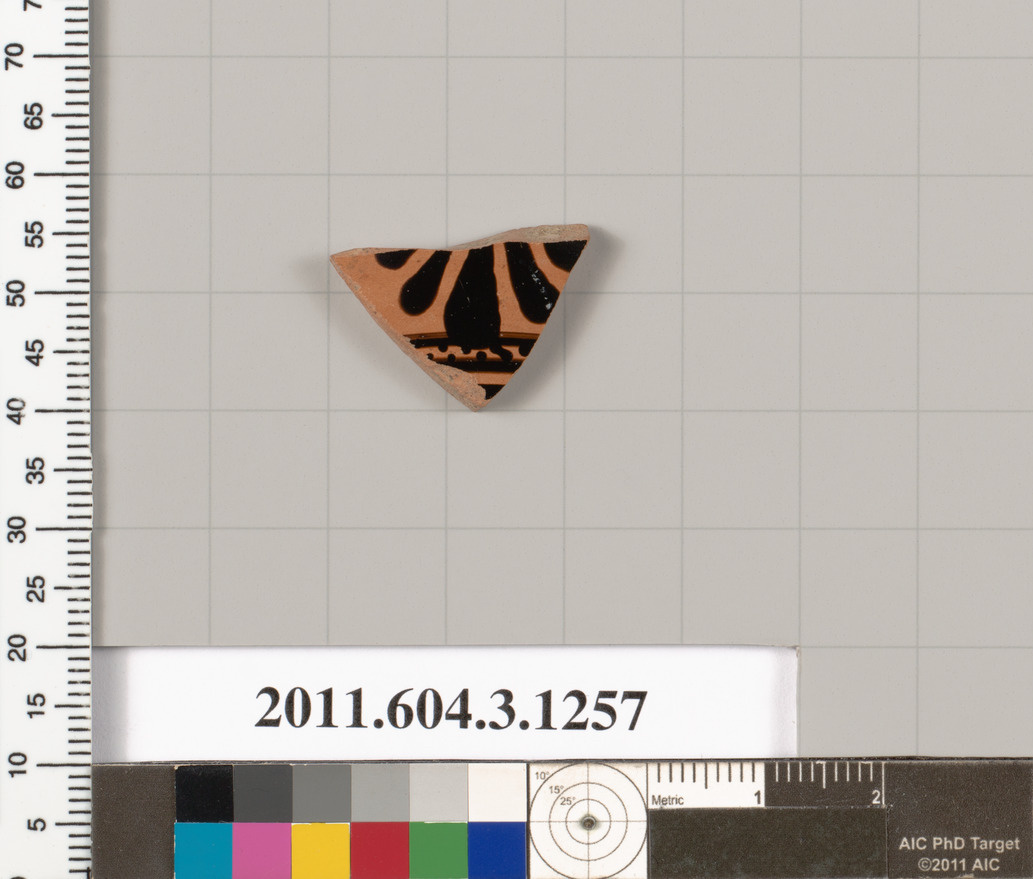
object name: skyphos fragment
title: Terracotta fragment of a skyphos (deep drinking cup)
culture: greek, attic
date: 534-468 BCE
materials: terracotta